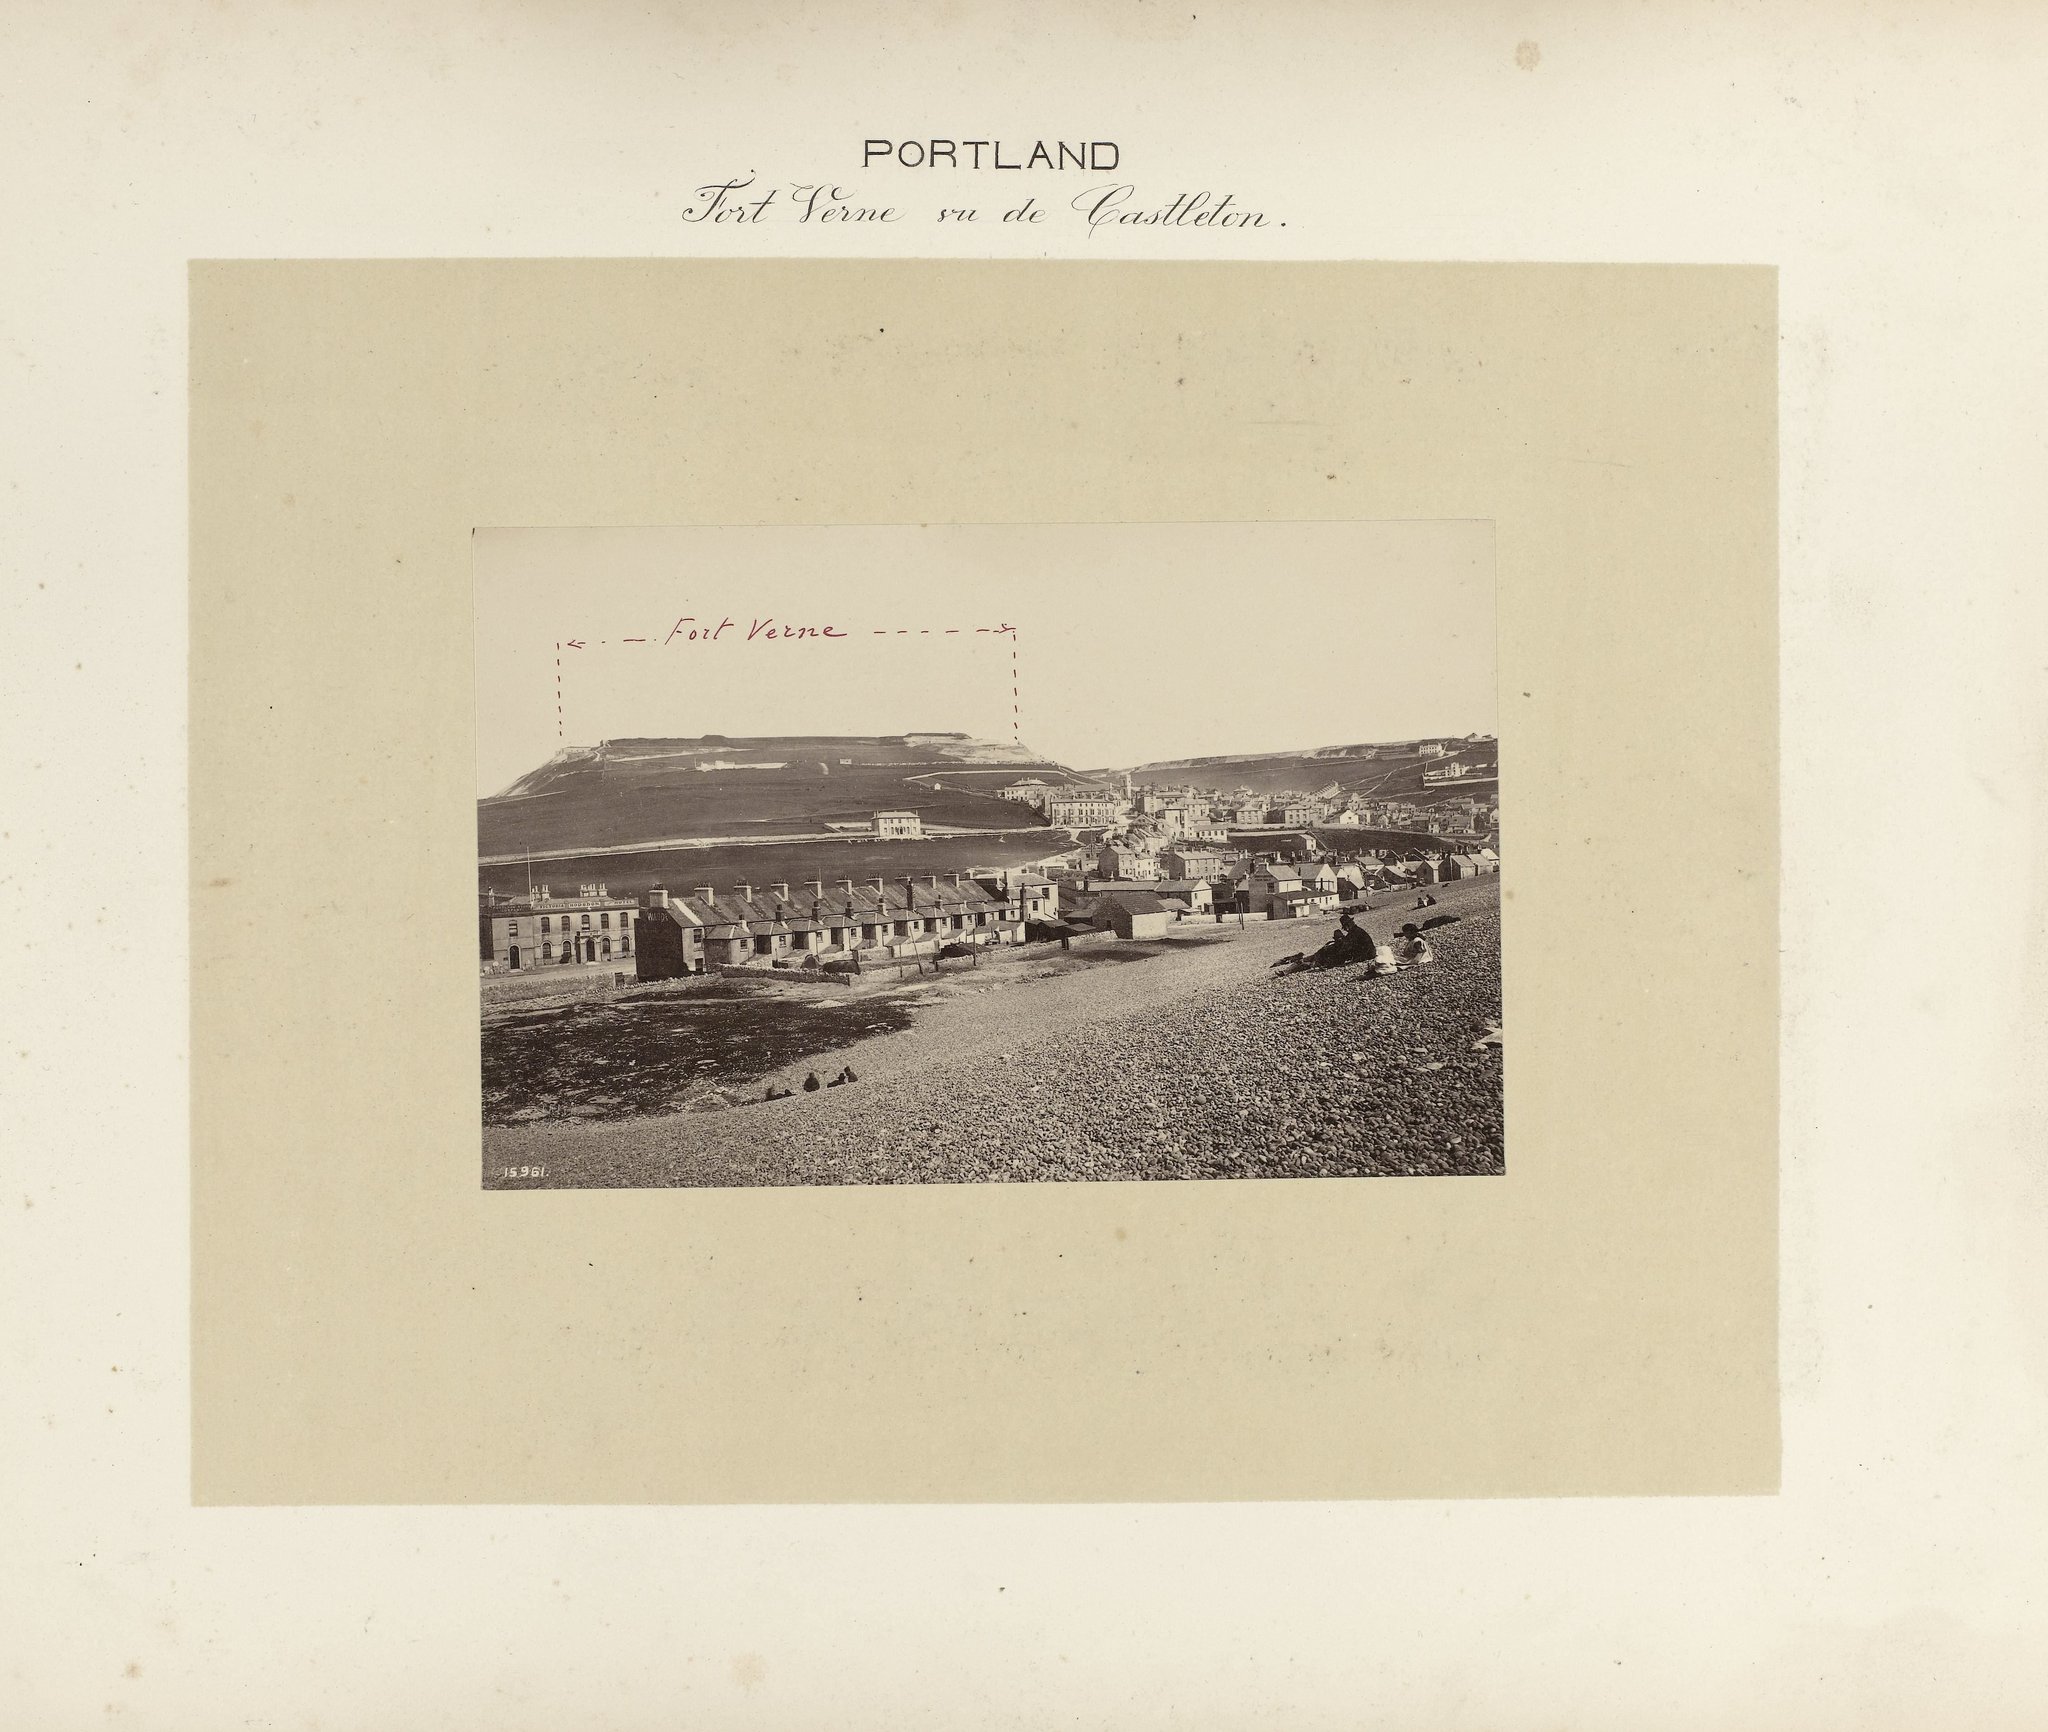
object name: photograph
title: Gezicht op Portland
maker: Anonymous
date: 1891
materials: cardboard, paper, photographic support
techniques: albumen print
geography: great britain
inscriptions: inscription: ‘PORTLAND / Fort Verne vu de Castleton’, annotation: ‘Fort Verne’, number: ‘15961’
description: Foto uit een album met 35 topografische foto's van Britse kustplaatsen, waarop in pen militaire verdedigingswerken zijn aangegeven door een Franse militair.